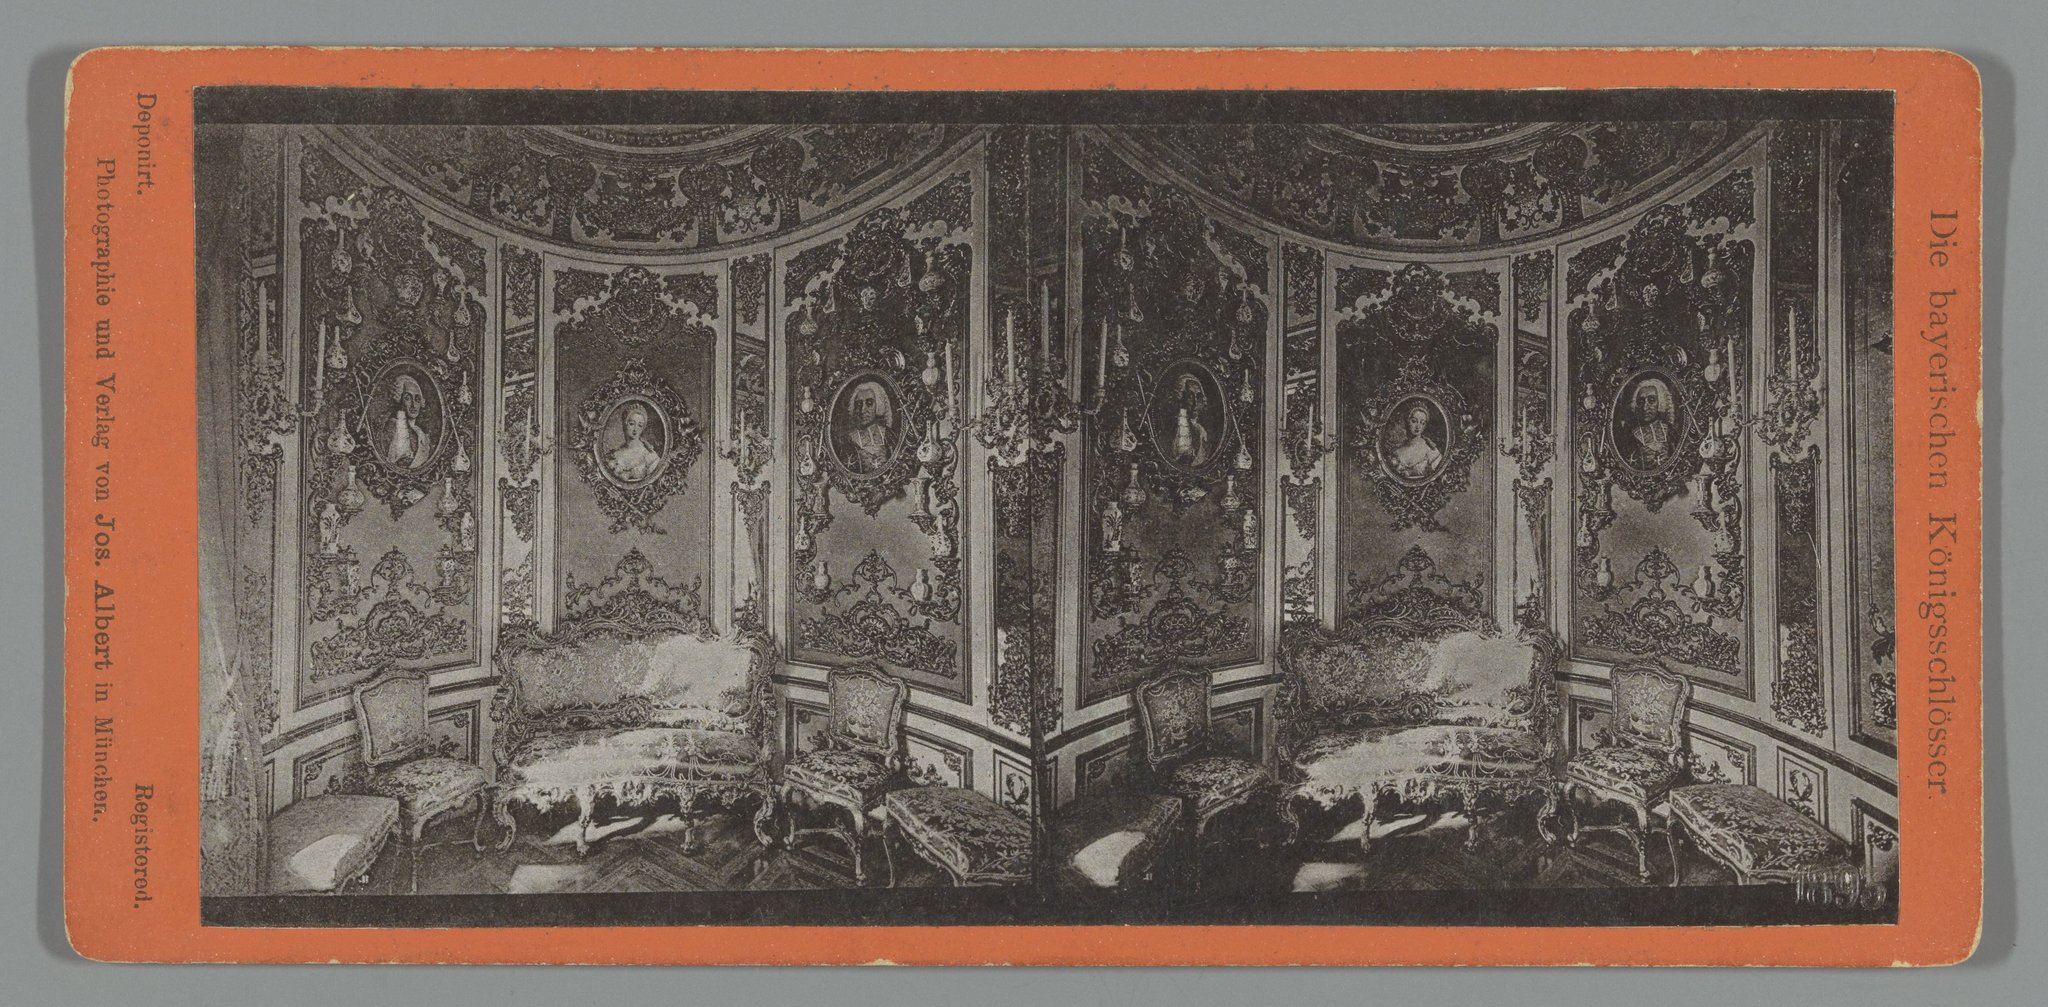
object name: photomechanical print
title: Die bayerischen Königsschlösser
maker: joseph albert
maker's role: printer, publisher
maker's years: 1825-1886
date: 1885-1886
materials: cardboard, paper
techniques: photograph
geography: slot linderhof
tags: drawing-room, 'salon', palace, interior ~ representation of a building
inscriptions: number: ‘27.’